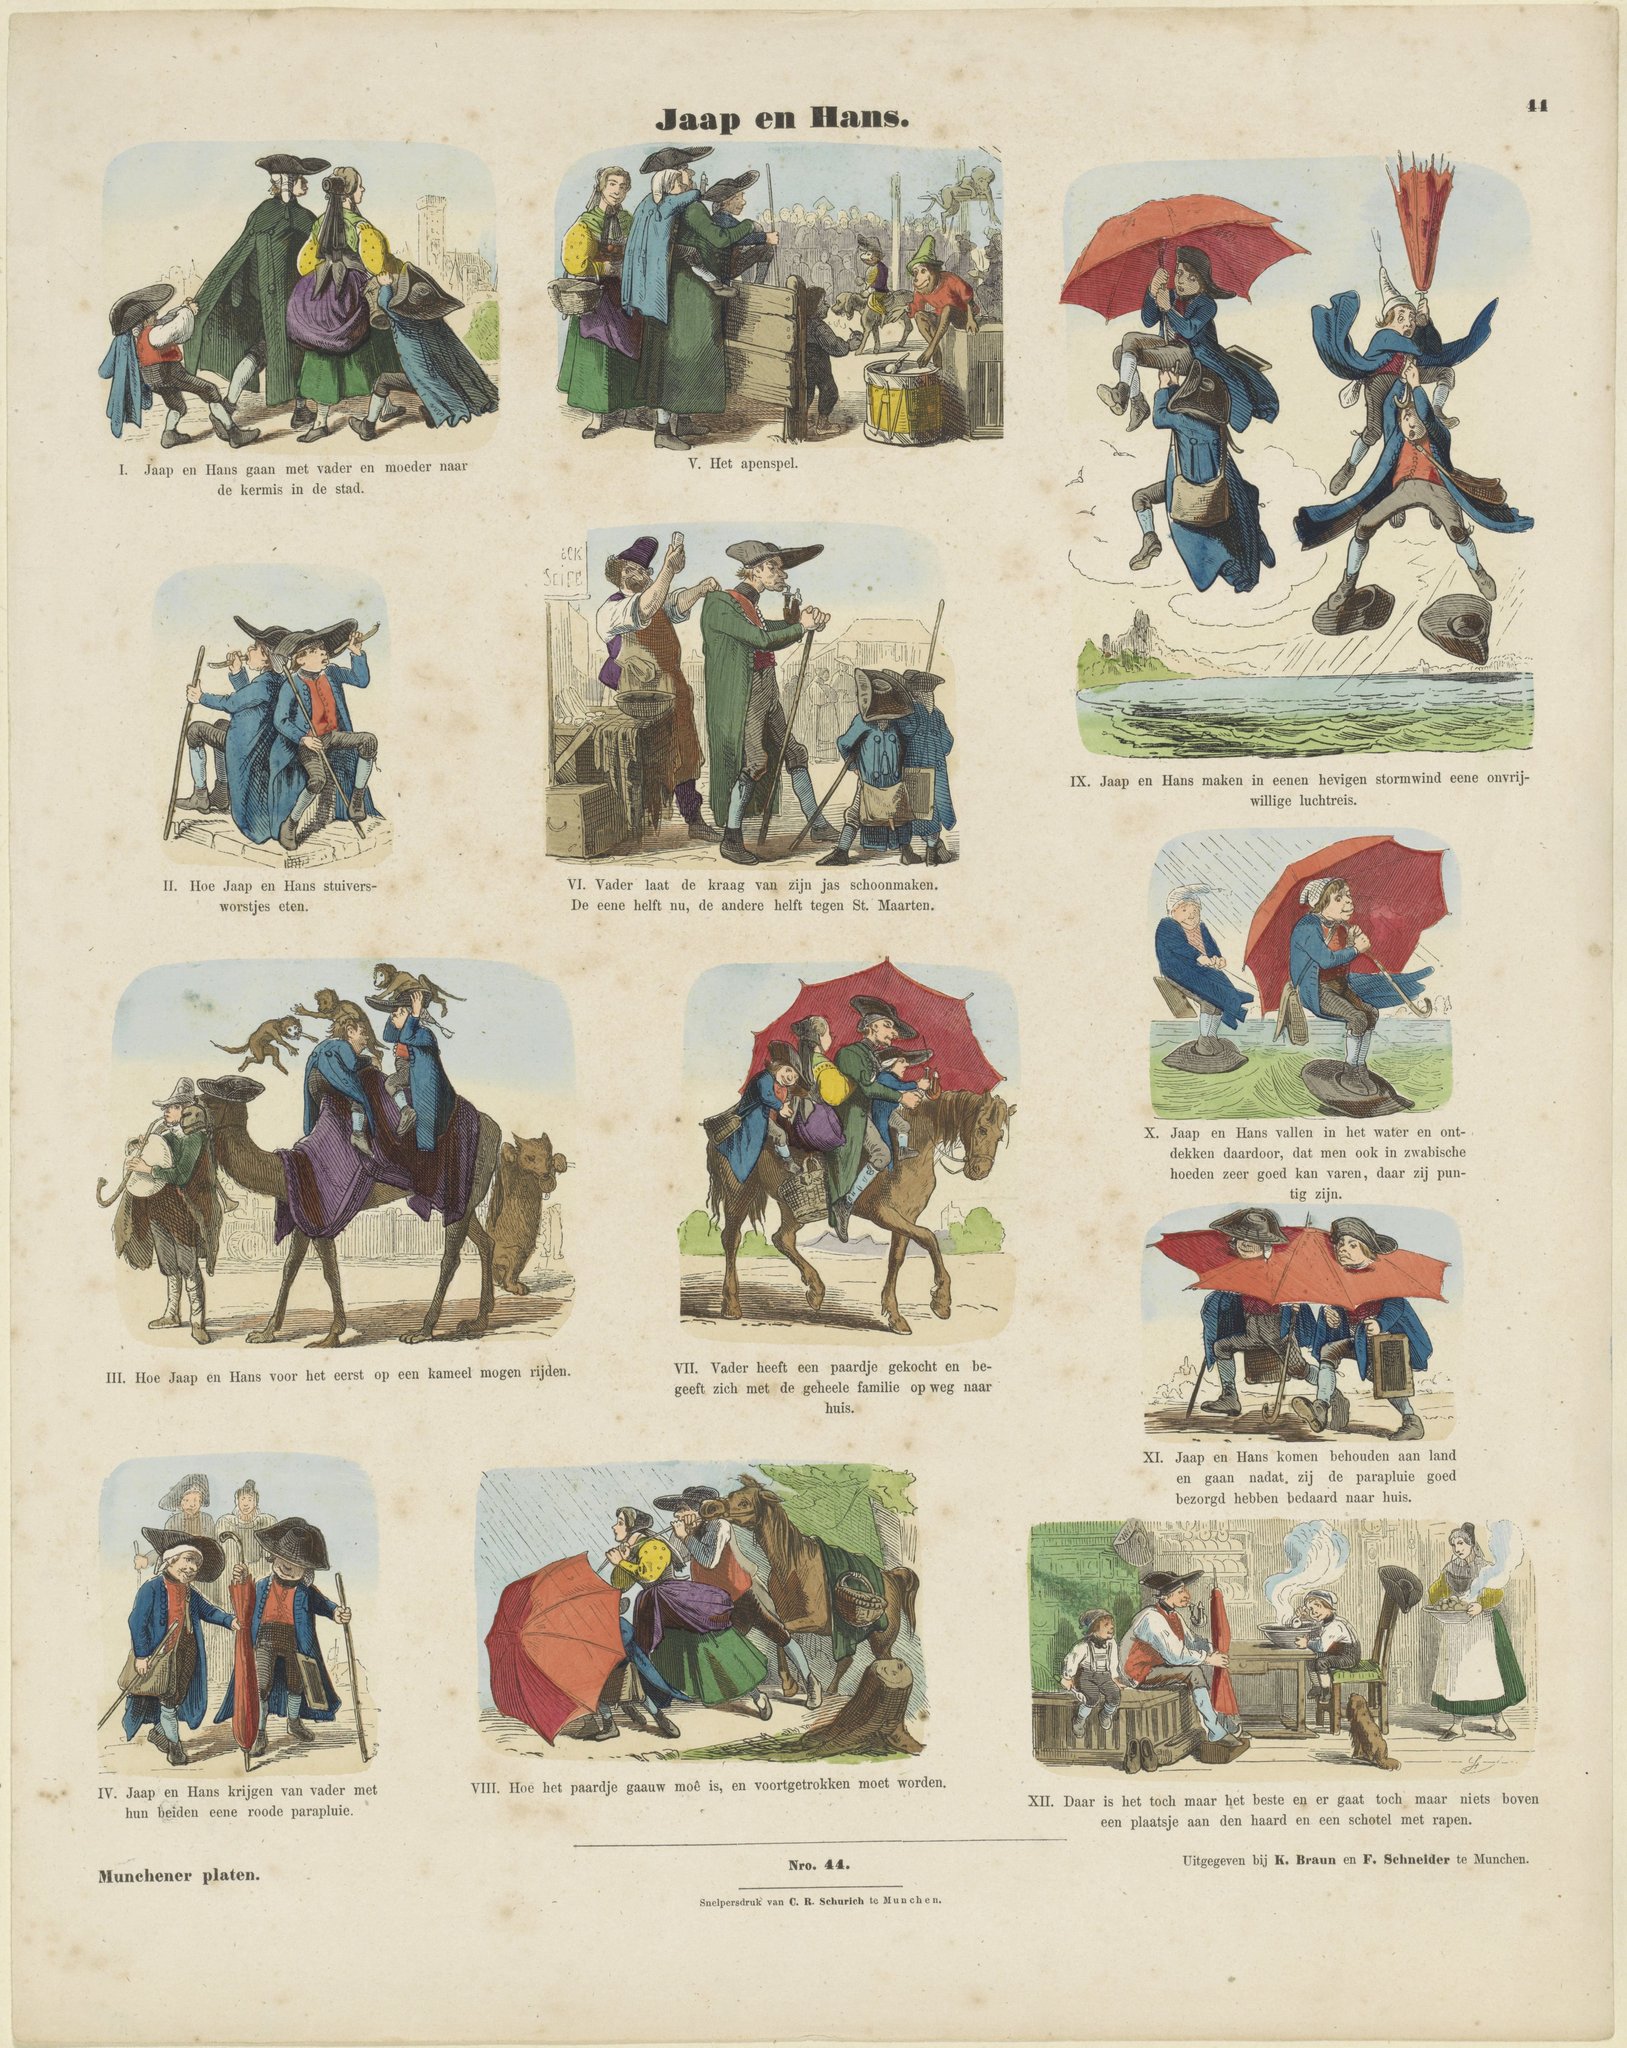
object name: print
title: Munchener platen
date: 1843-1920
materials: paper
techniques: colour, letterpress printing, engraving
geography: germany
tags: children (first degree family relationships), parents (first degree family relationships)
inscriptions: collector's mark: Lugt 2760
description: Blad met 12 voorstellingen over Jaap en Hans die met hun ouders naar de kermis gaan en in allerlei avonturen verzeild. Tenslotte realiseren ze zich dat de beste plek thuis is. Onder elke afbeelding een onderschrift. Genummerd midden onder: Nro. 44. Genummerd rechtsboven: 44.